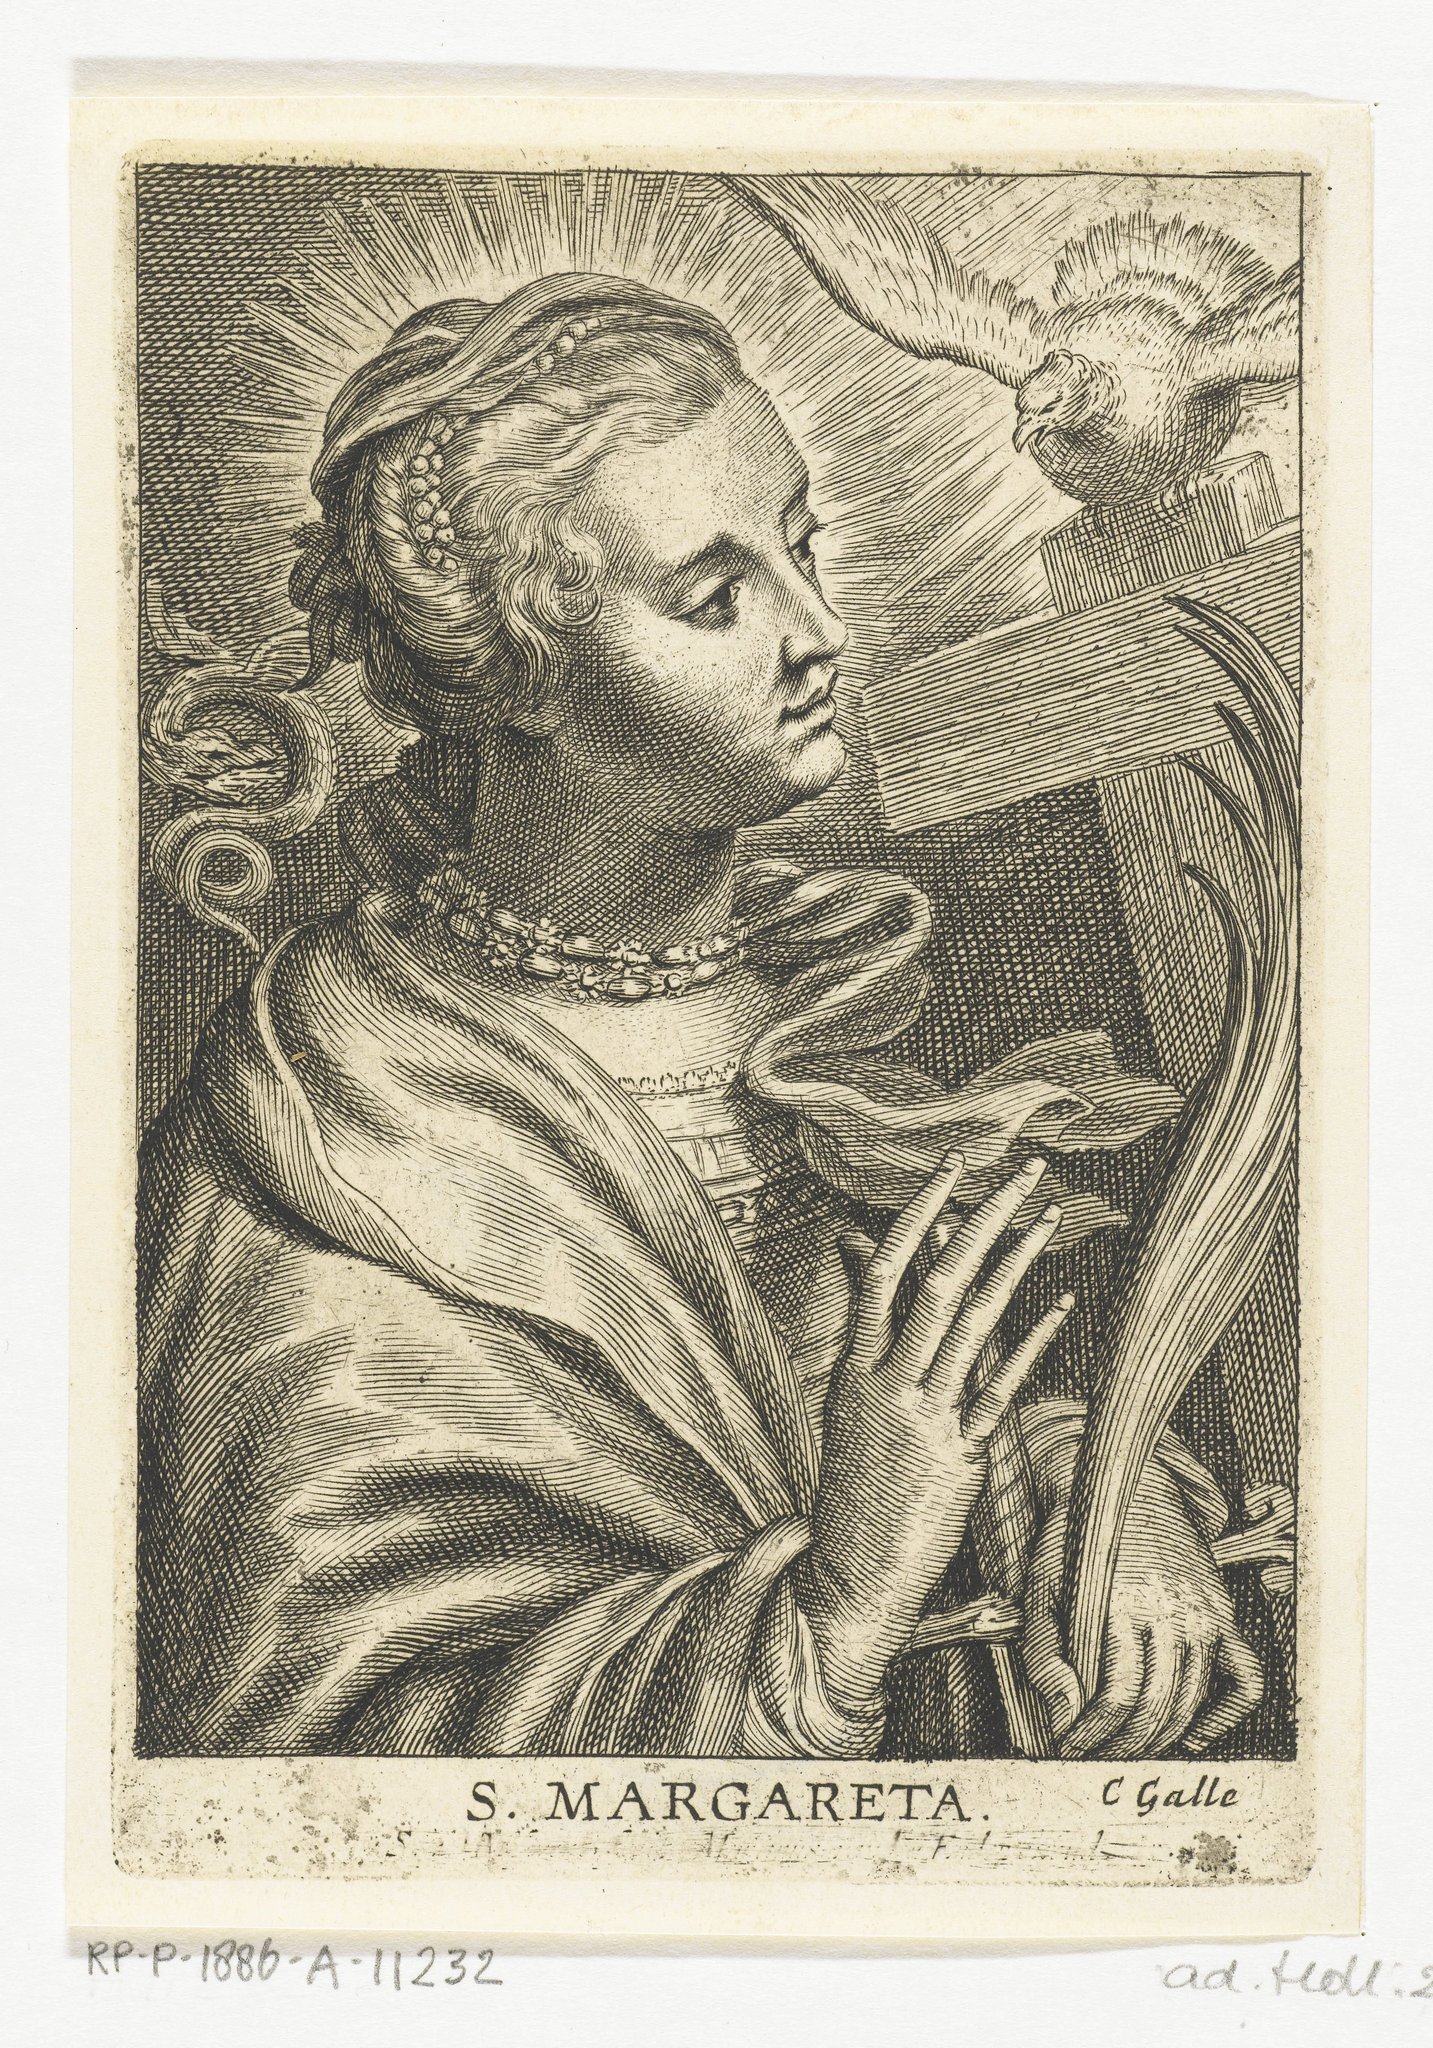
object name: print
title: Margareta van Antiochië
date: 1596-1659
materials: paper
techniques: engraving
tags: the virgin martyr margaret of antioch; possible attributes: cross, crown, dragon (under feet or on chain), (chaplet of) pearls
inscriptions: collector's mark: Lugt 2228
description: Met parels, zwaard, palmtak en draak. Rechts de H. Geest. Voorheen geïdentificeerd als de H. Margareta van Cortona.